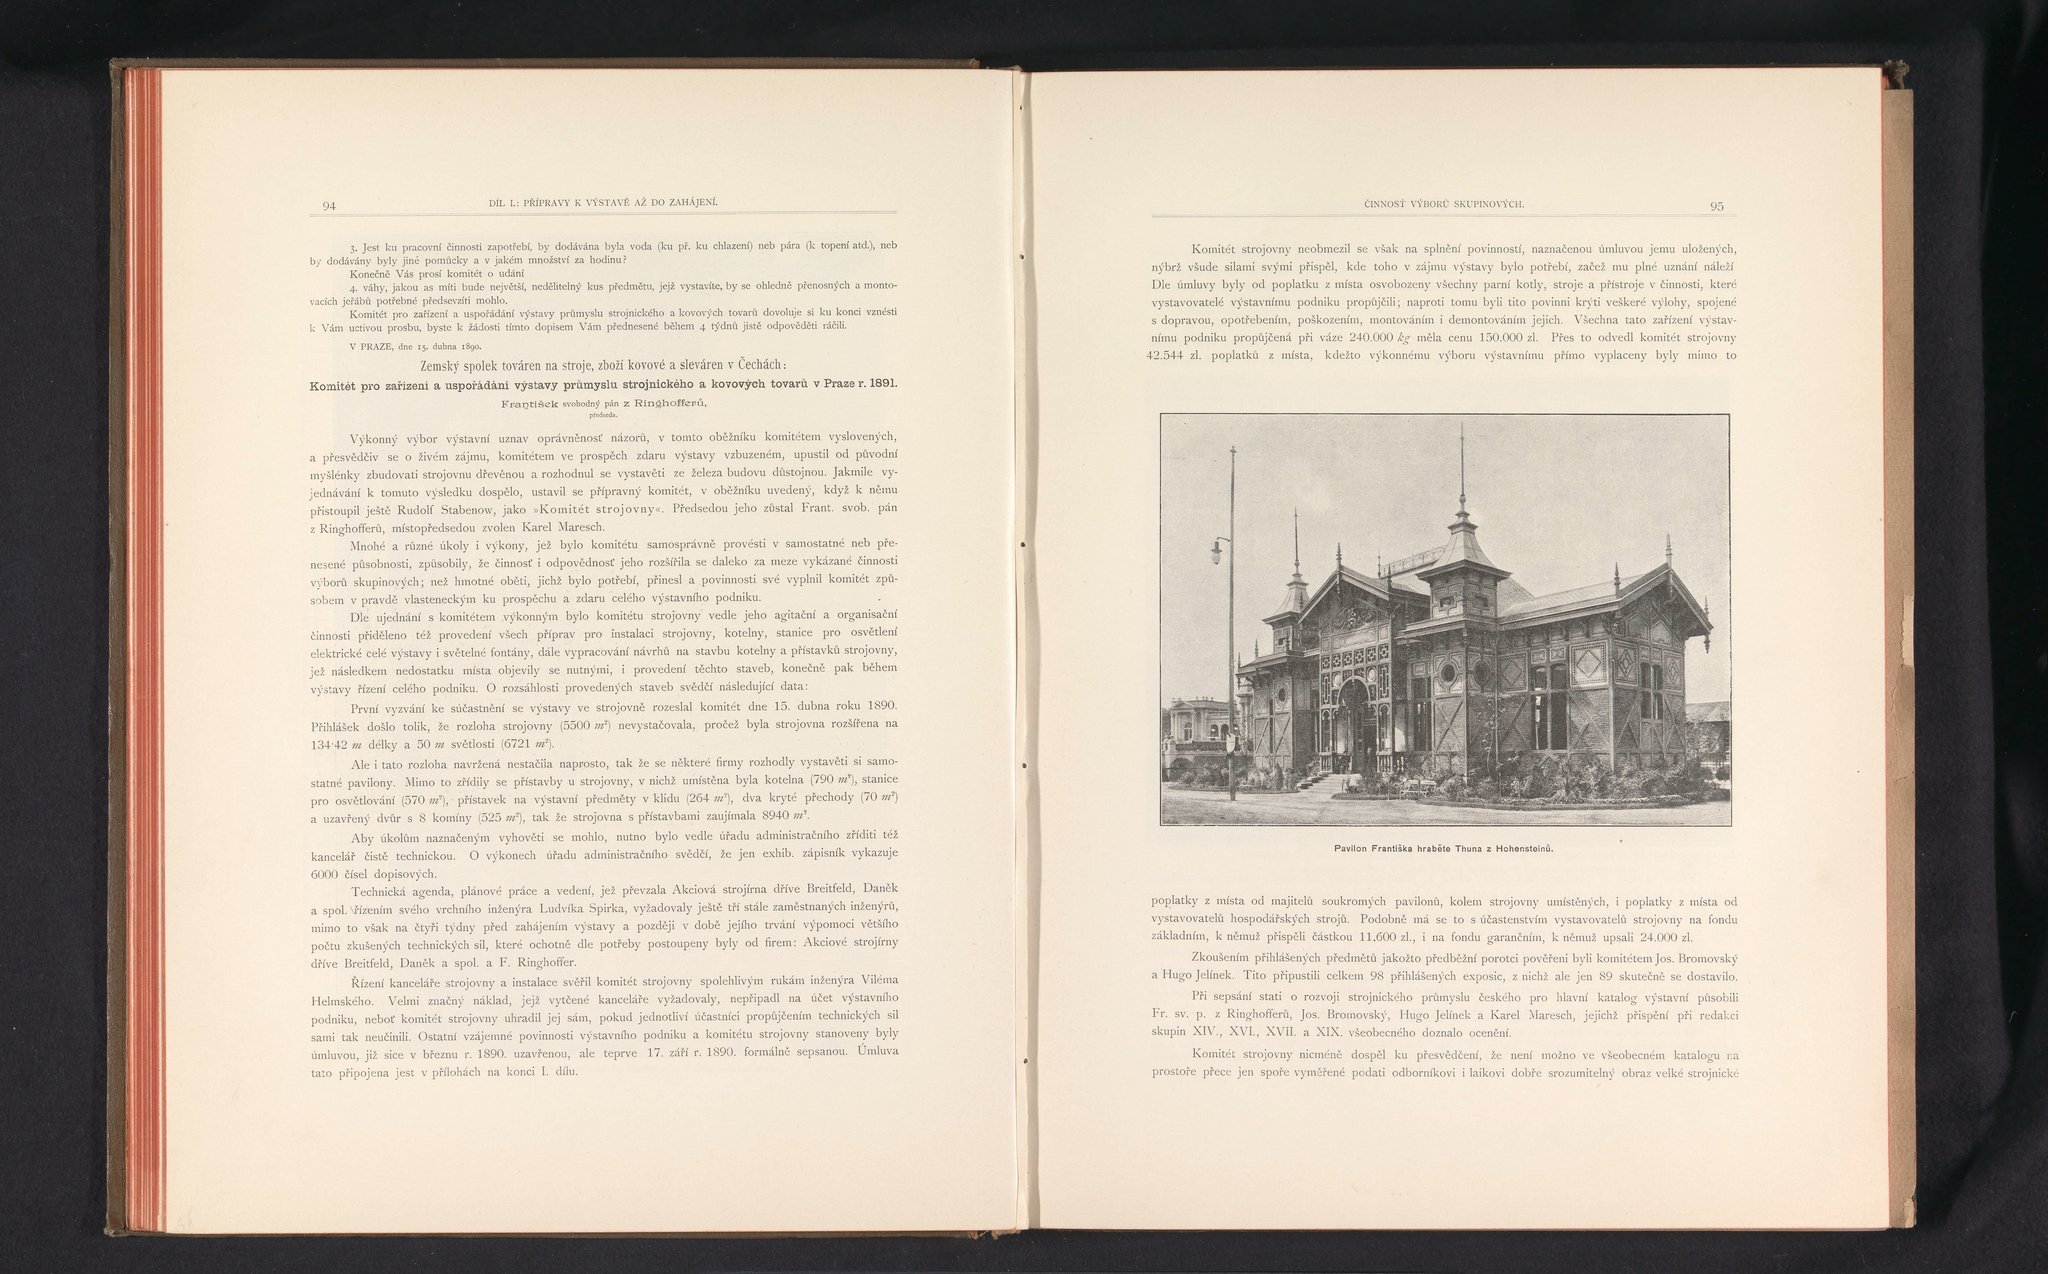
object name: page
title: Pavilon Frantiska hrabete Thuna z Hohensteinu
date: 1888-1893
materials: paper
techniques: autotype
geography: prague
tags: housing, façade (of house or building)